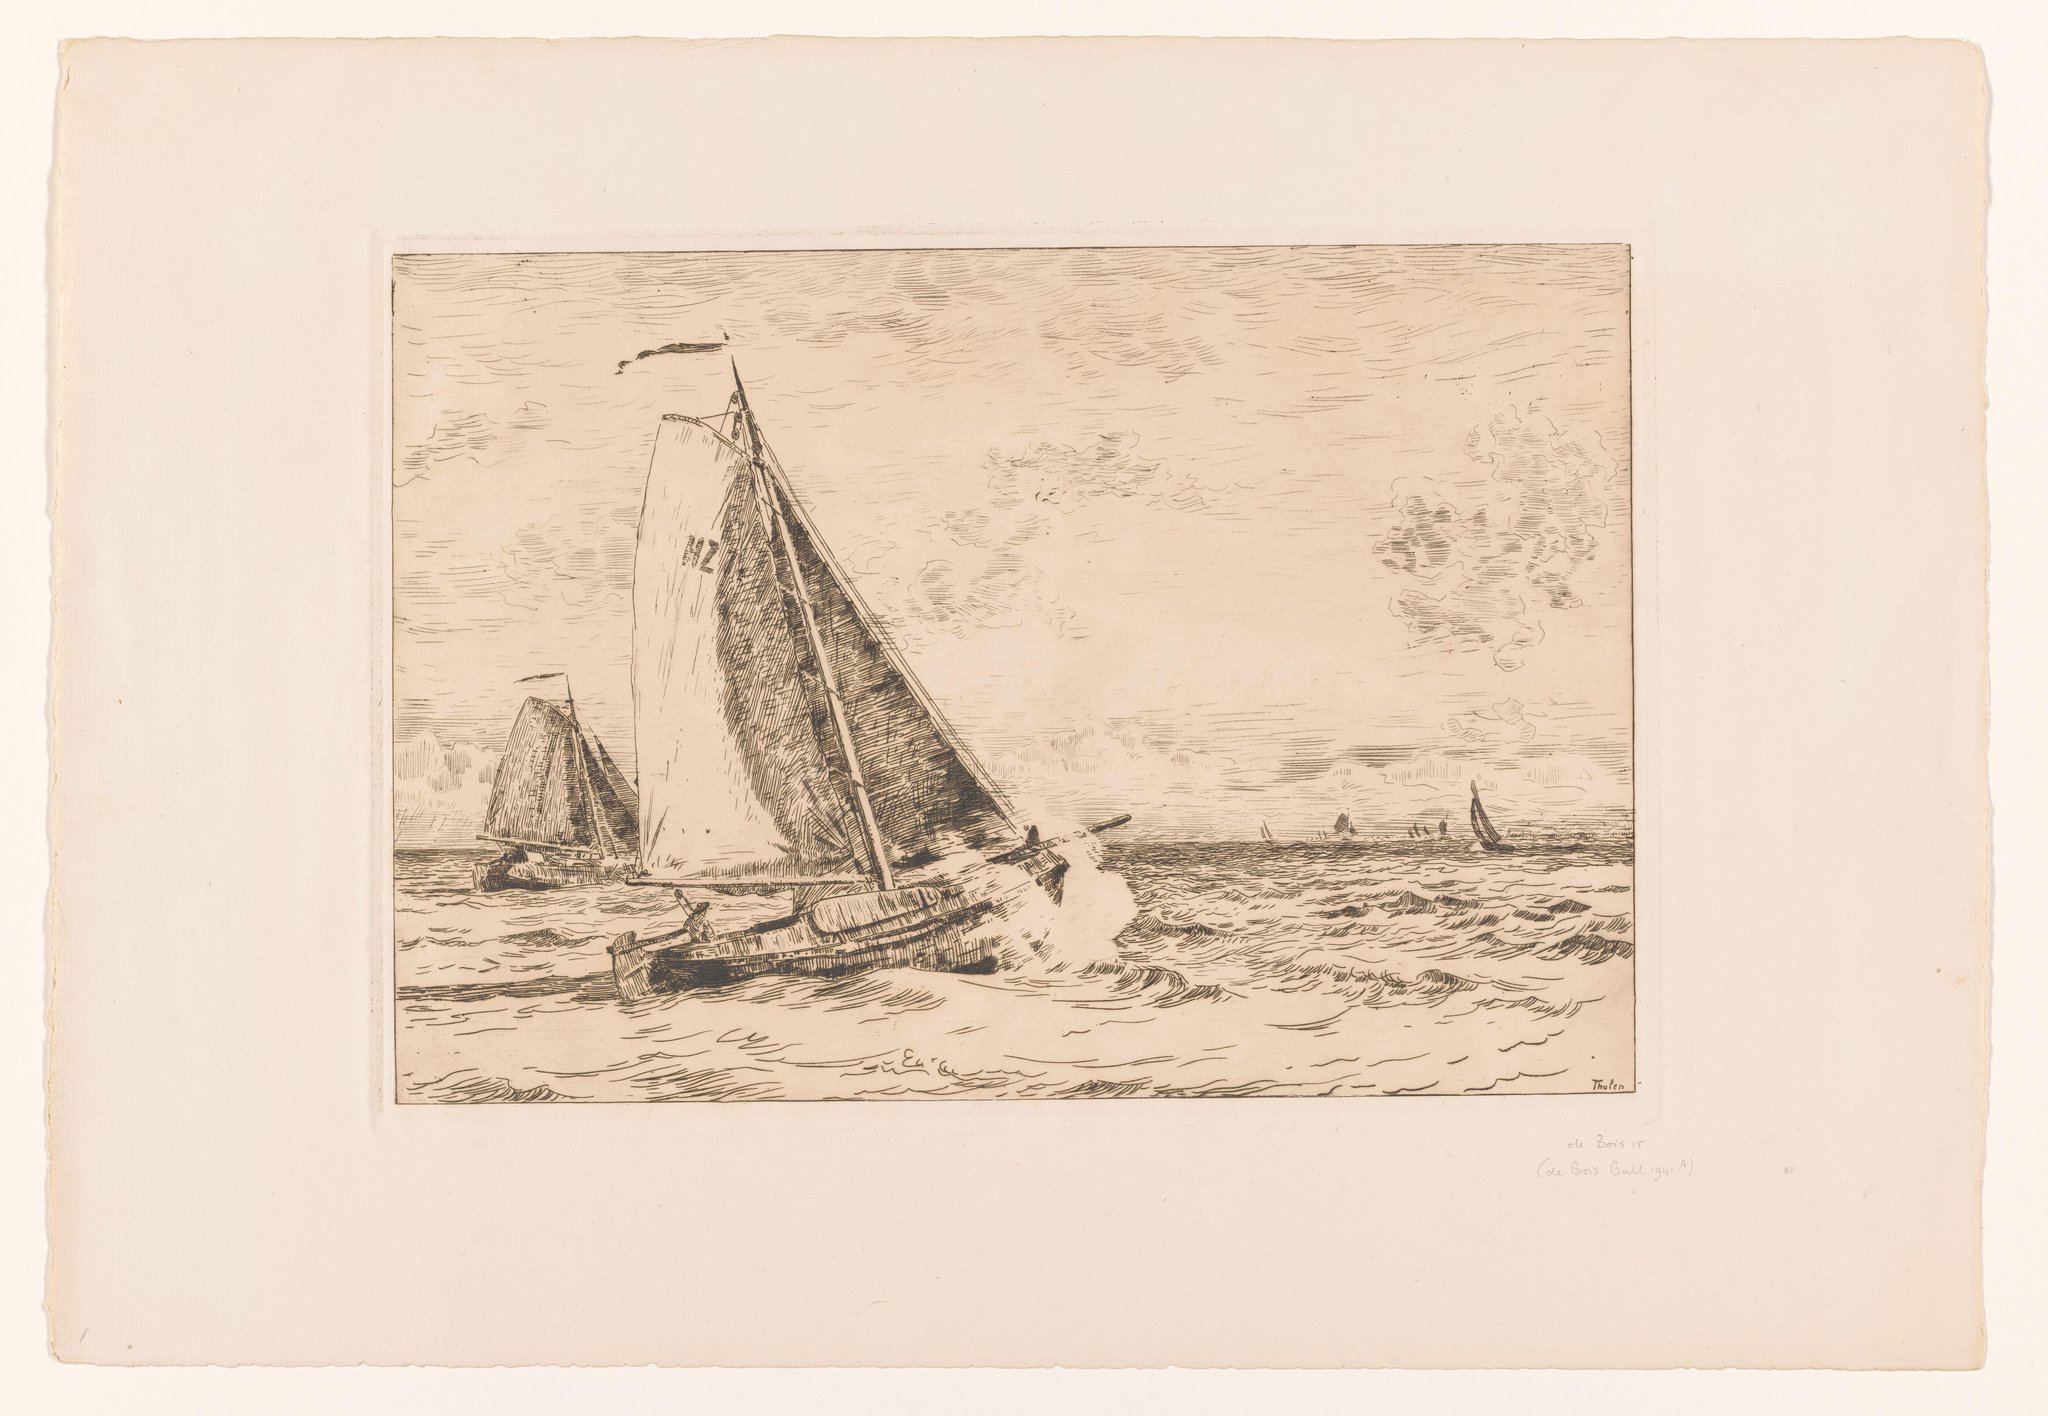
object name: print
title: Zeilende schepen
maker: willem bastiaan tholen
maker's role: draughtsman, painter, print maker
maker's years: 1860-1931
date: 1870-1931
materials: paper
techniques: etching, intaglio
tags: sailing-ship, sailing-boat, zuiderzee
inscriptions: collector's mark: Lugt 2228